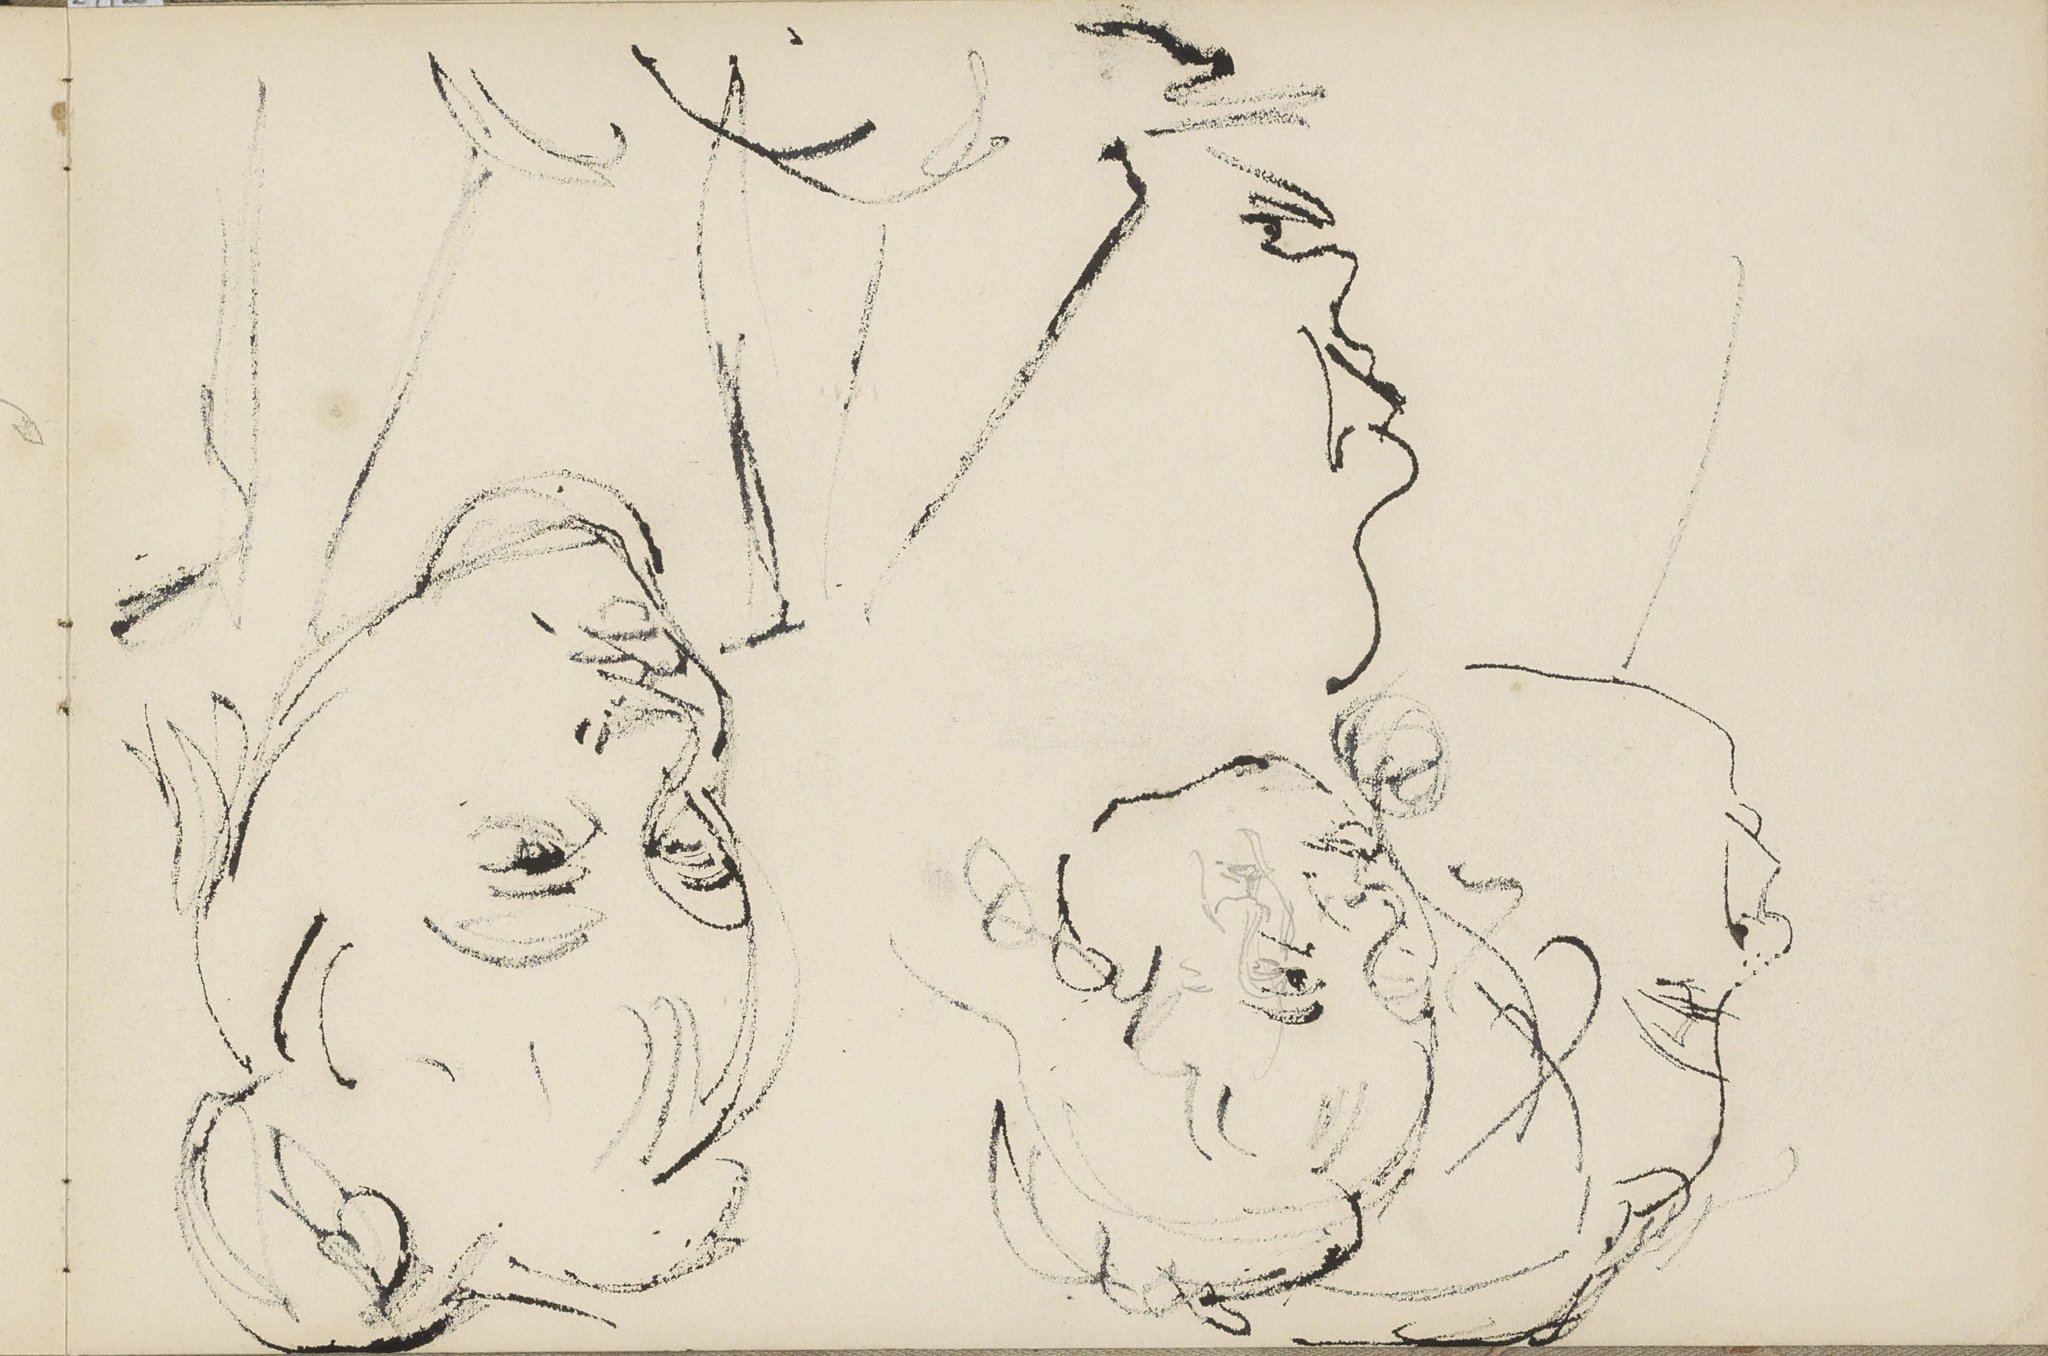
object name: sketchbook leaf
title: Koppen van kinderen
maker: carel adolph lion cachet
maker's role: draughtsman, print maker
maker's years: 1864-1945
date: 1908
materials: ink, paper, pencil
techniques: pen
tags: head (human), child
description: Blad 24 recto uit een schetsboek met 25 bladen.